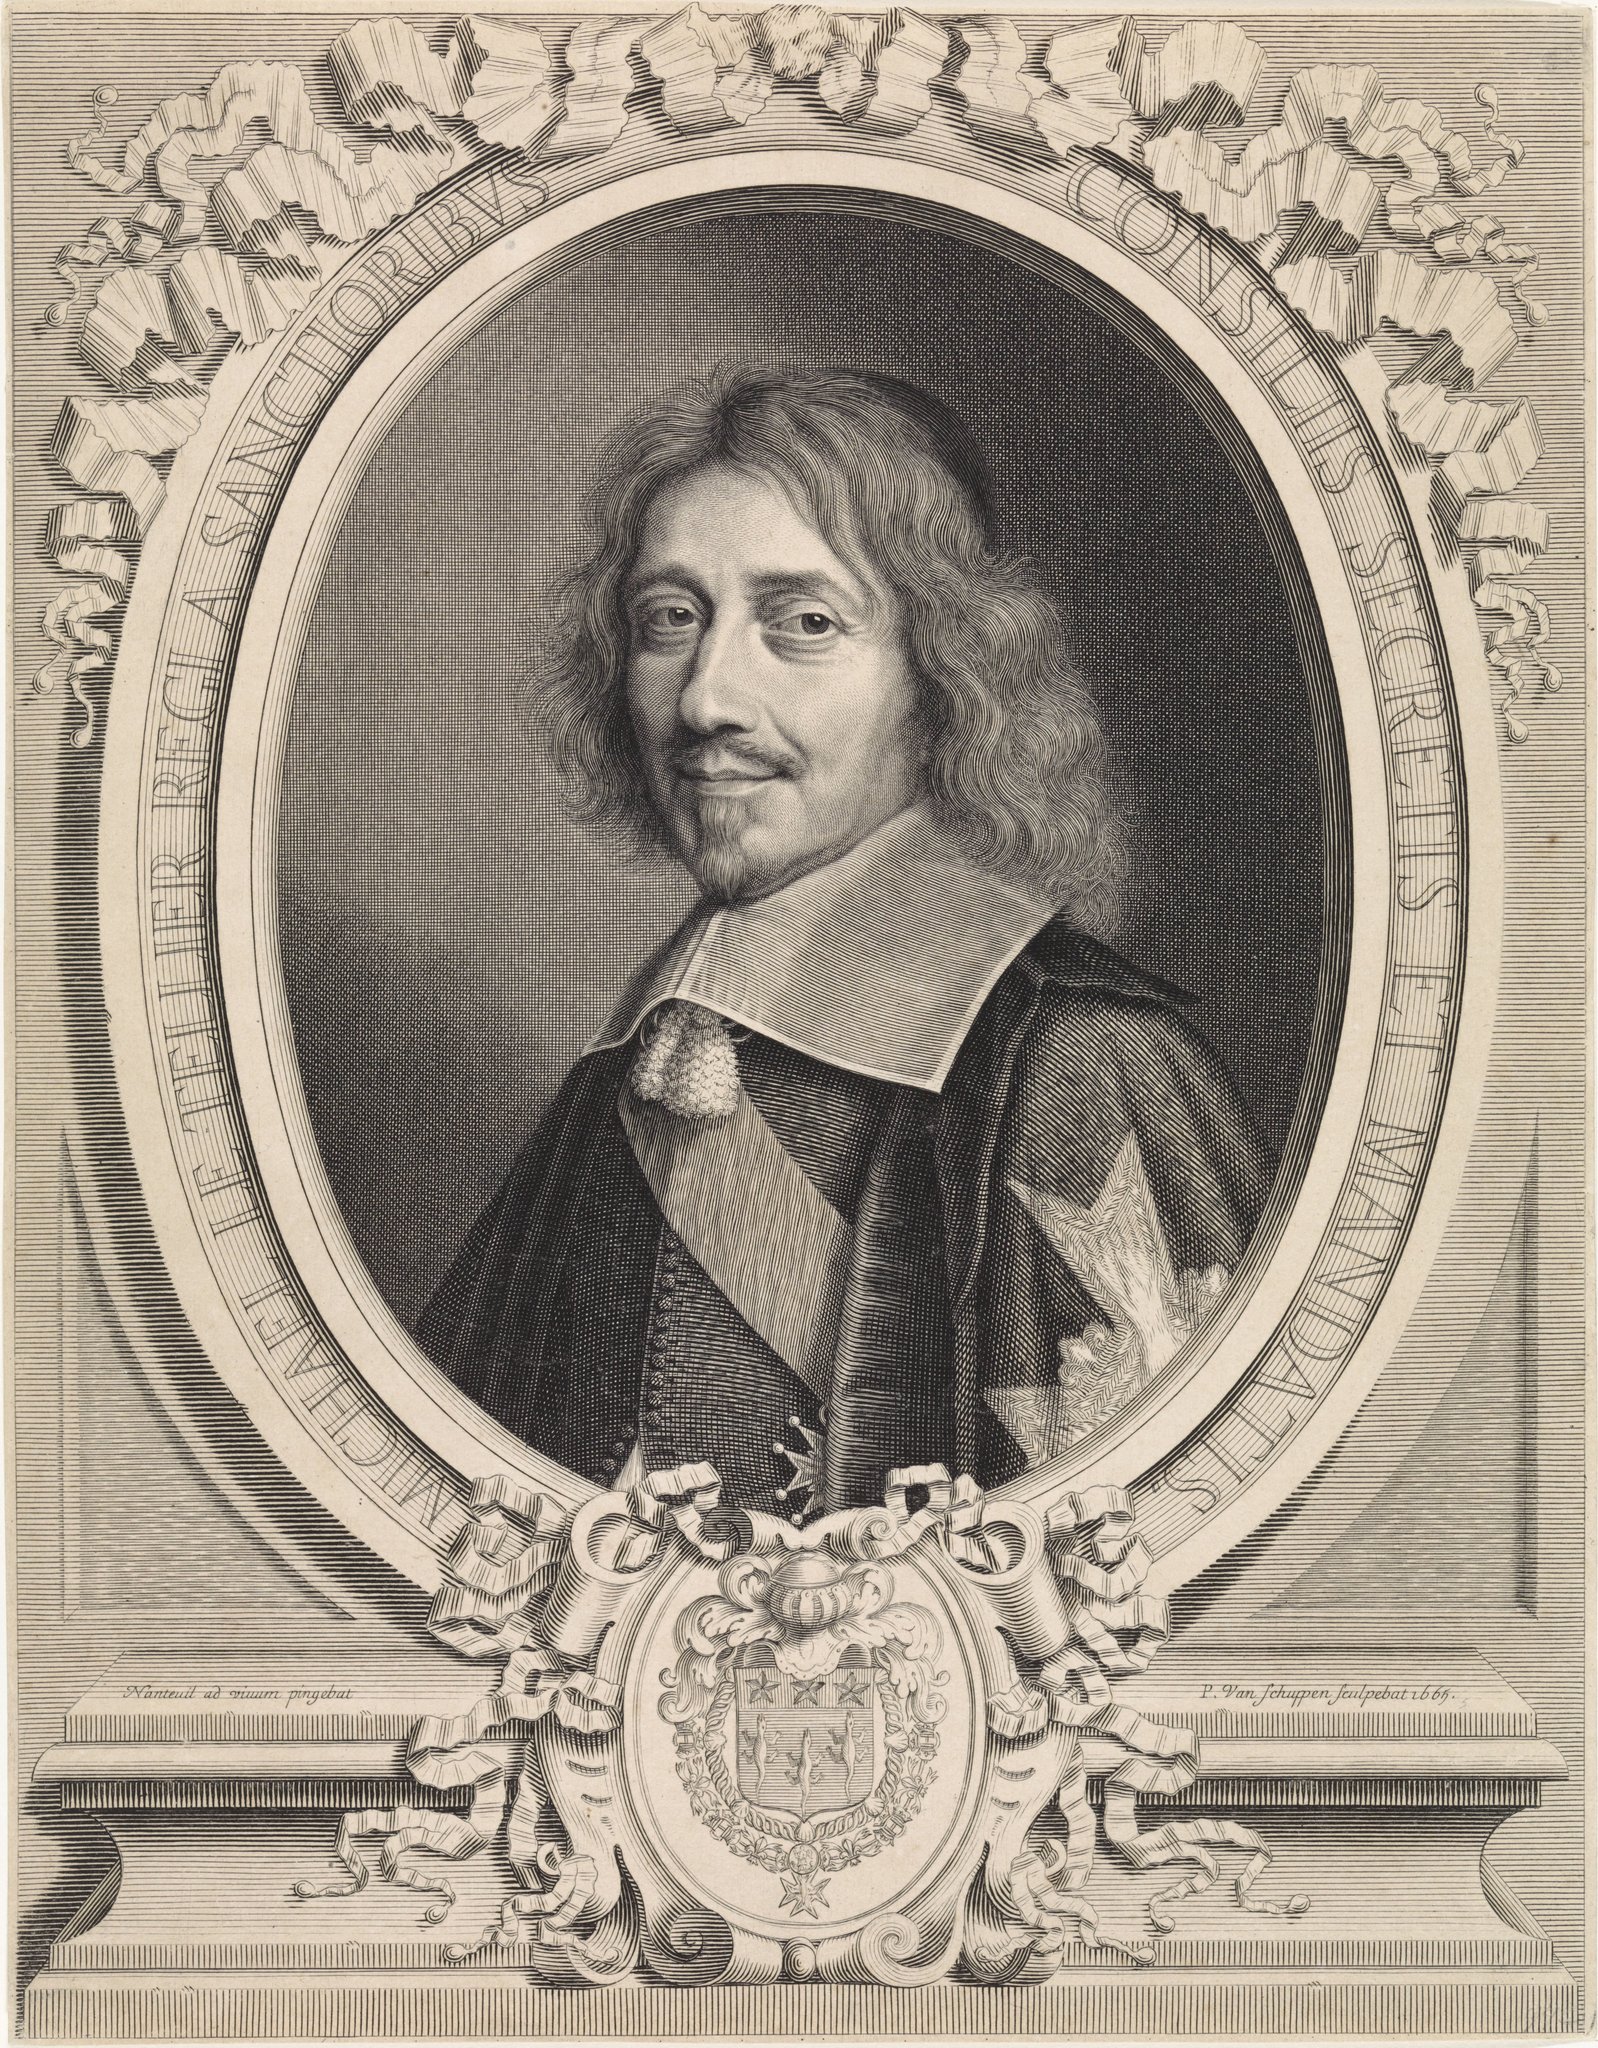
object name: print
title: Portret van Michel Le Tellier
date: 1605-1665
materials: paper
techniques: engraving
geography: paris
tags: paris, michel le tellier, knighthood order of the holy spirit - insignia of a knighthood order, e.g.: badge, chain (with name of order)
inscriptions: collector's mark: Lugt 2228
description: Portret van Michel Le Tellier. Op zijn mouw is met borduursel het kruis van de Orde van de Heilige Geest aangebracht. Onder het portret zijn wapenschild en in de omlijsting zijn naam en functie als adviseur van de koning.